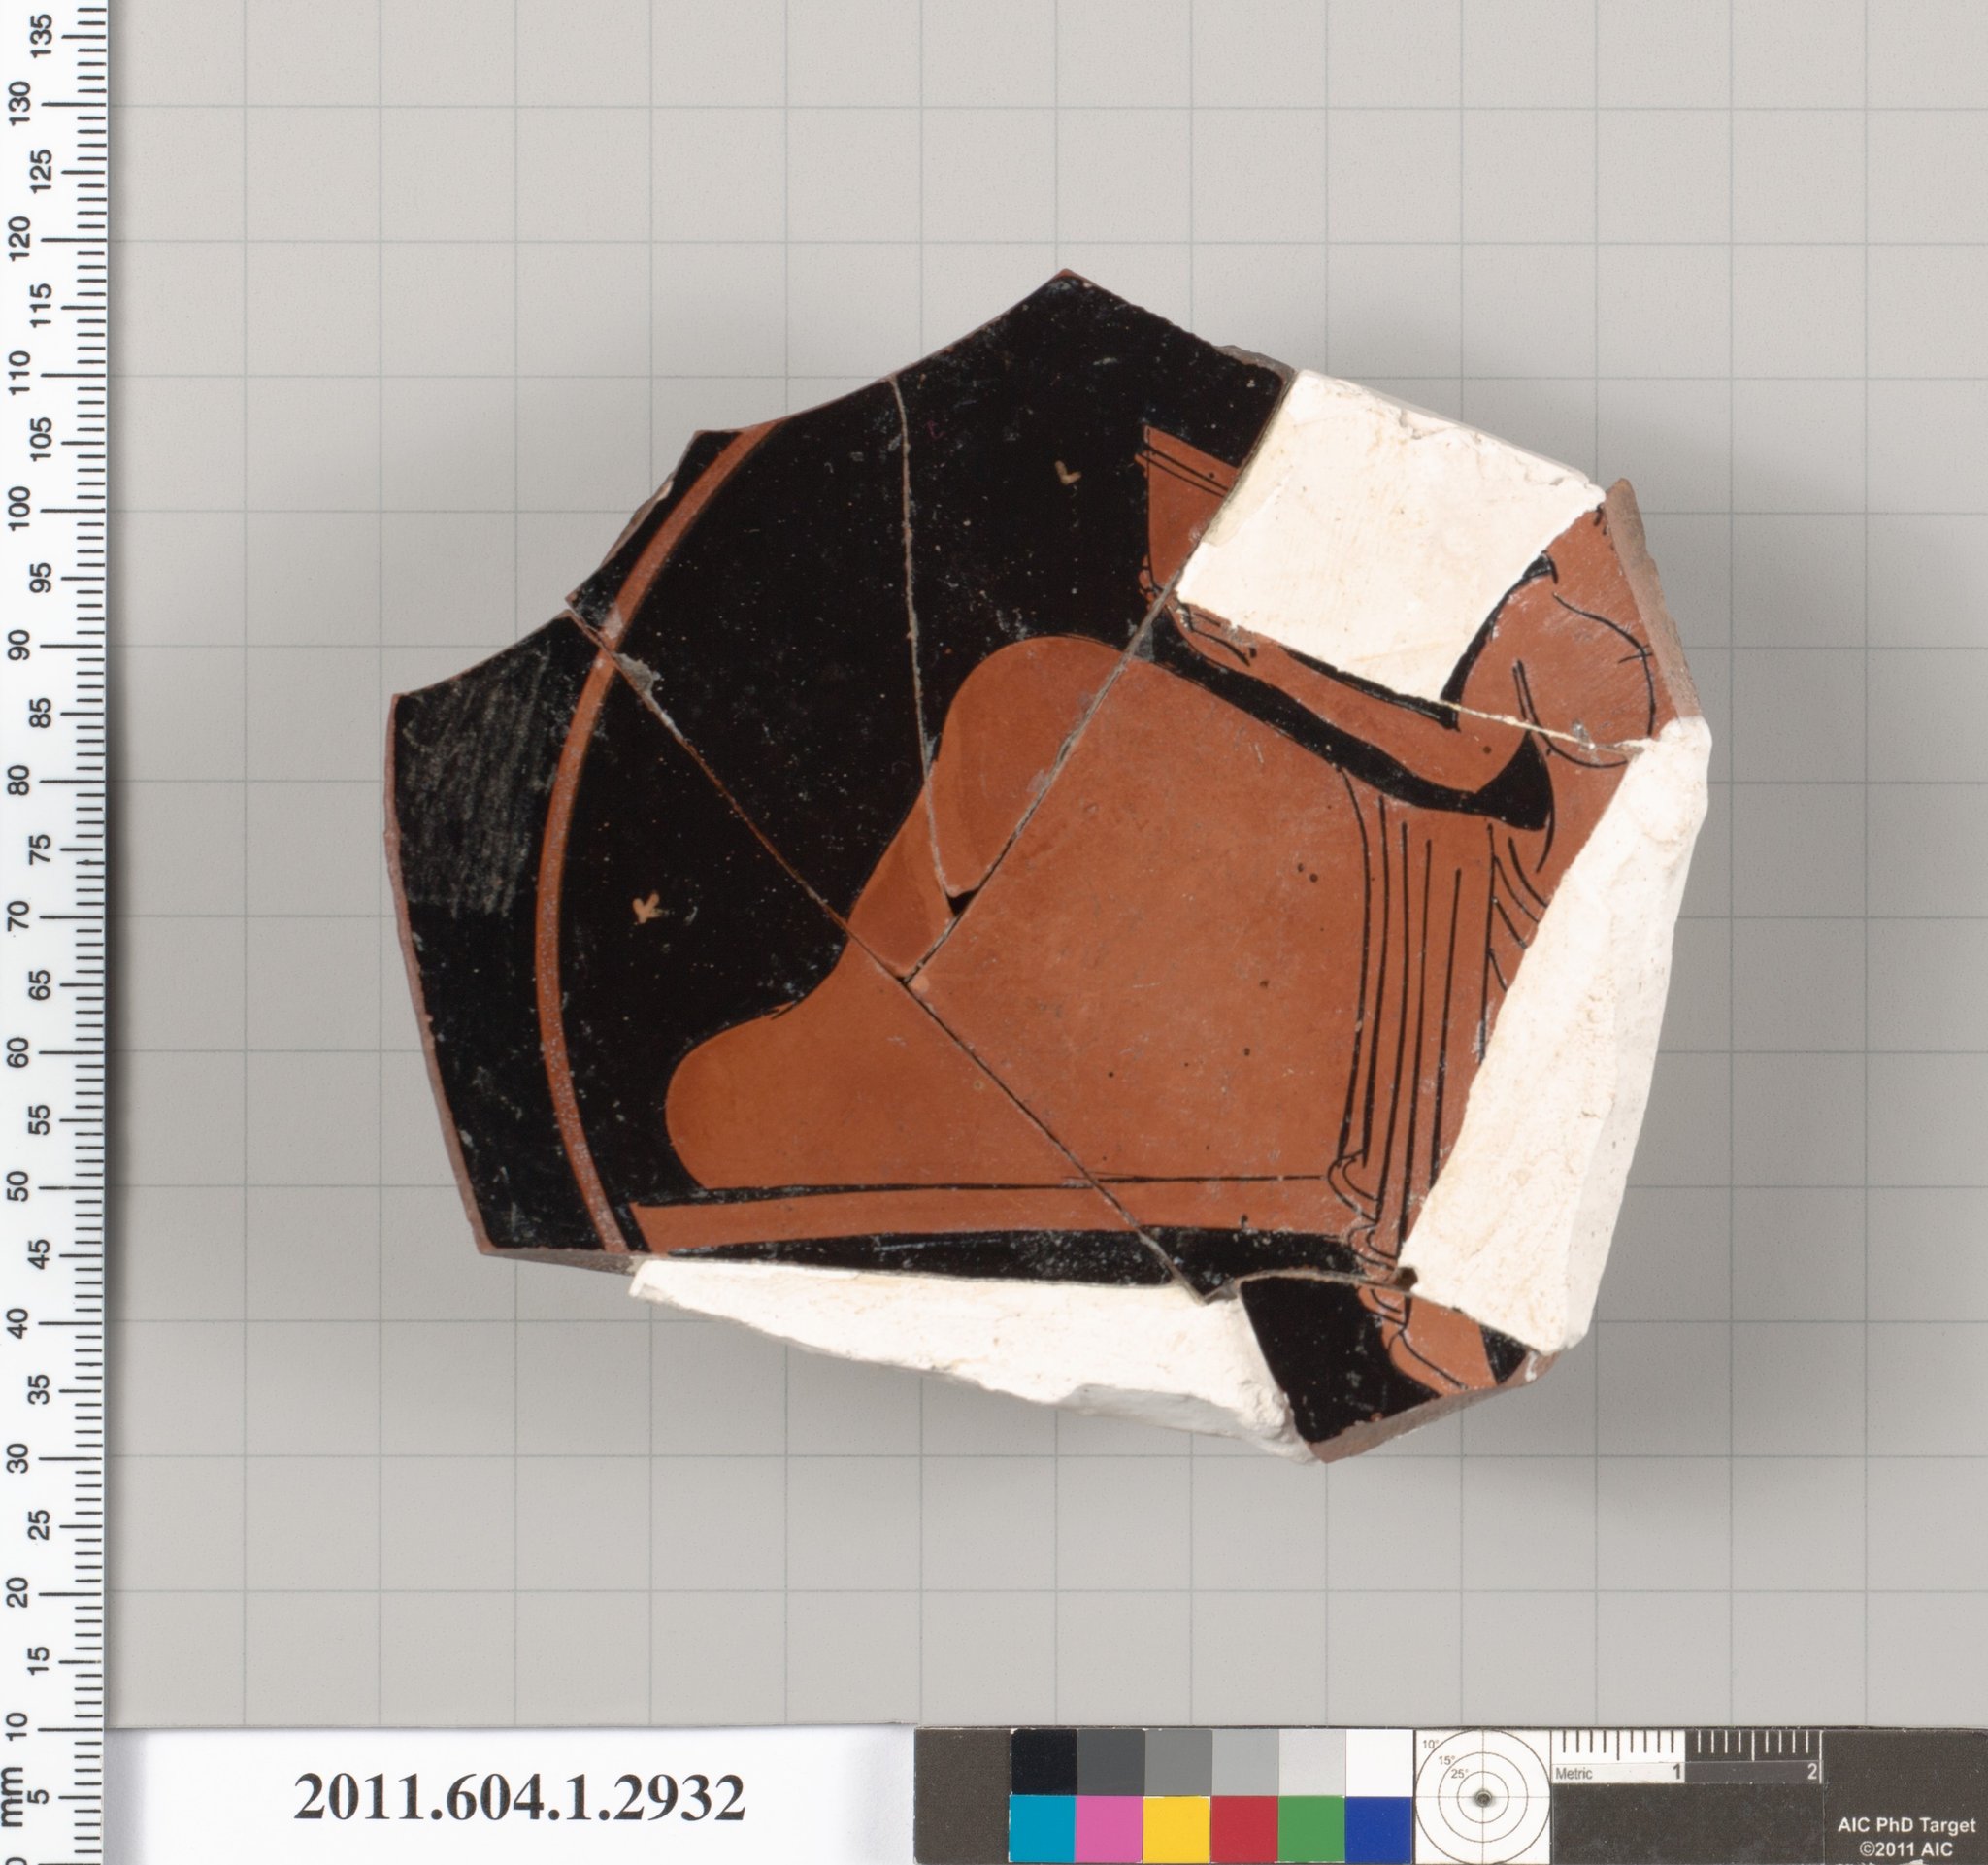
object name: kylix fragment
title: Terracotta fragment of a kylix (drinking cup)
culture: greek, attic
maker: bowdoin-eye painter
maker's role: artist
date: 520-490 BCE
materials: terracotta